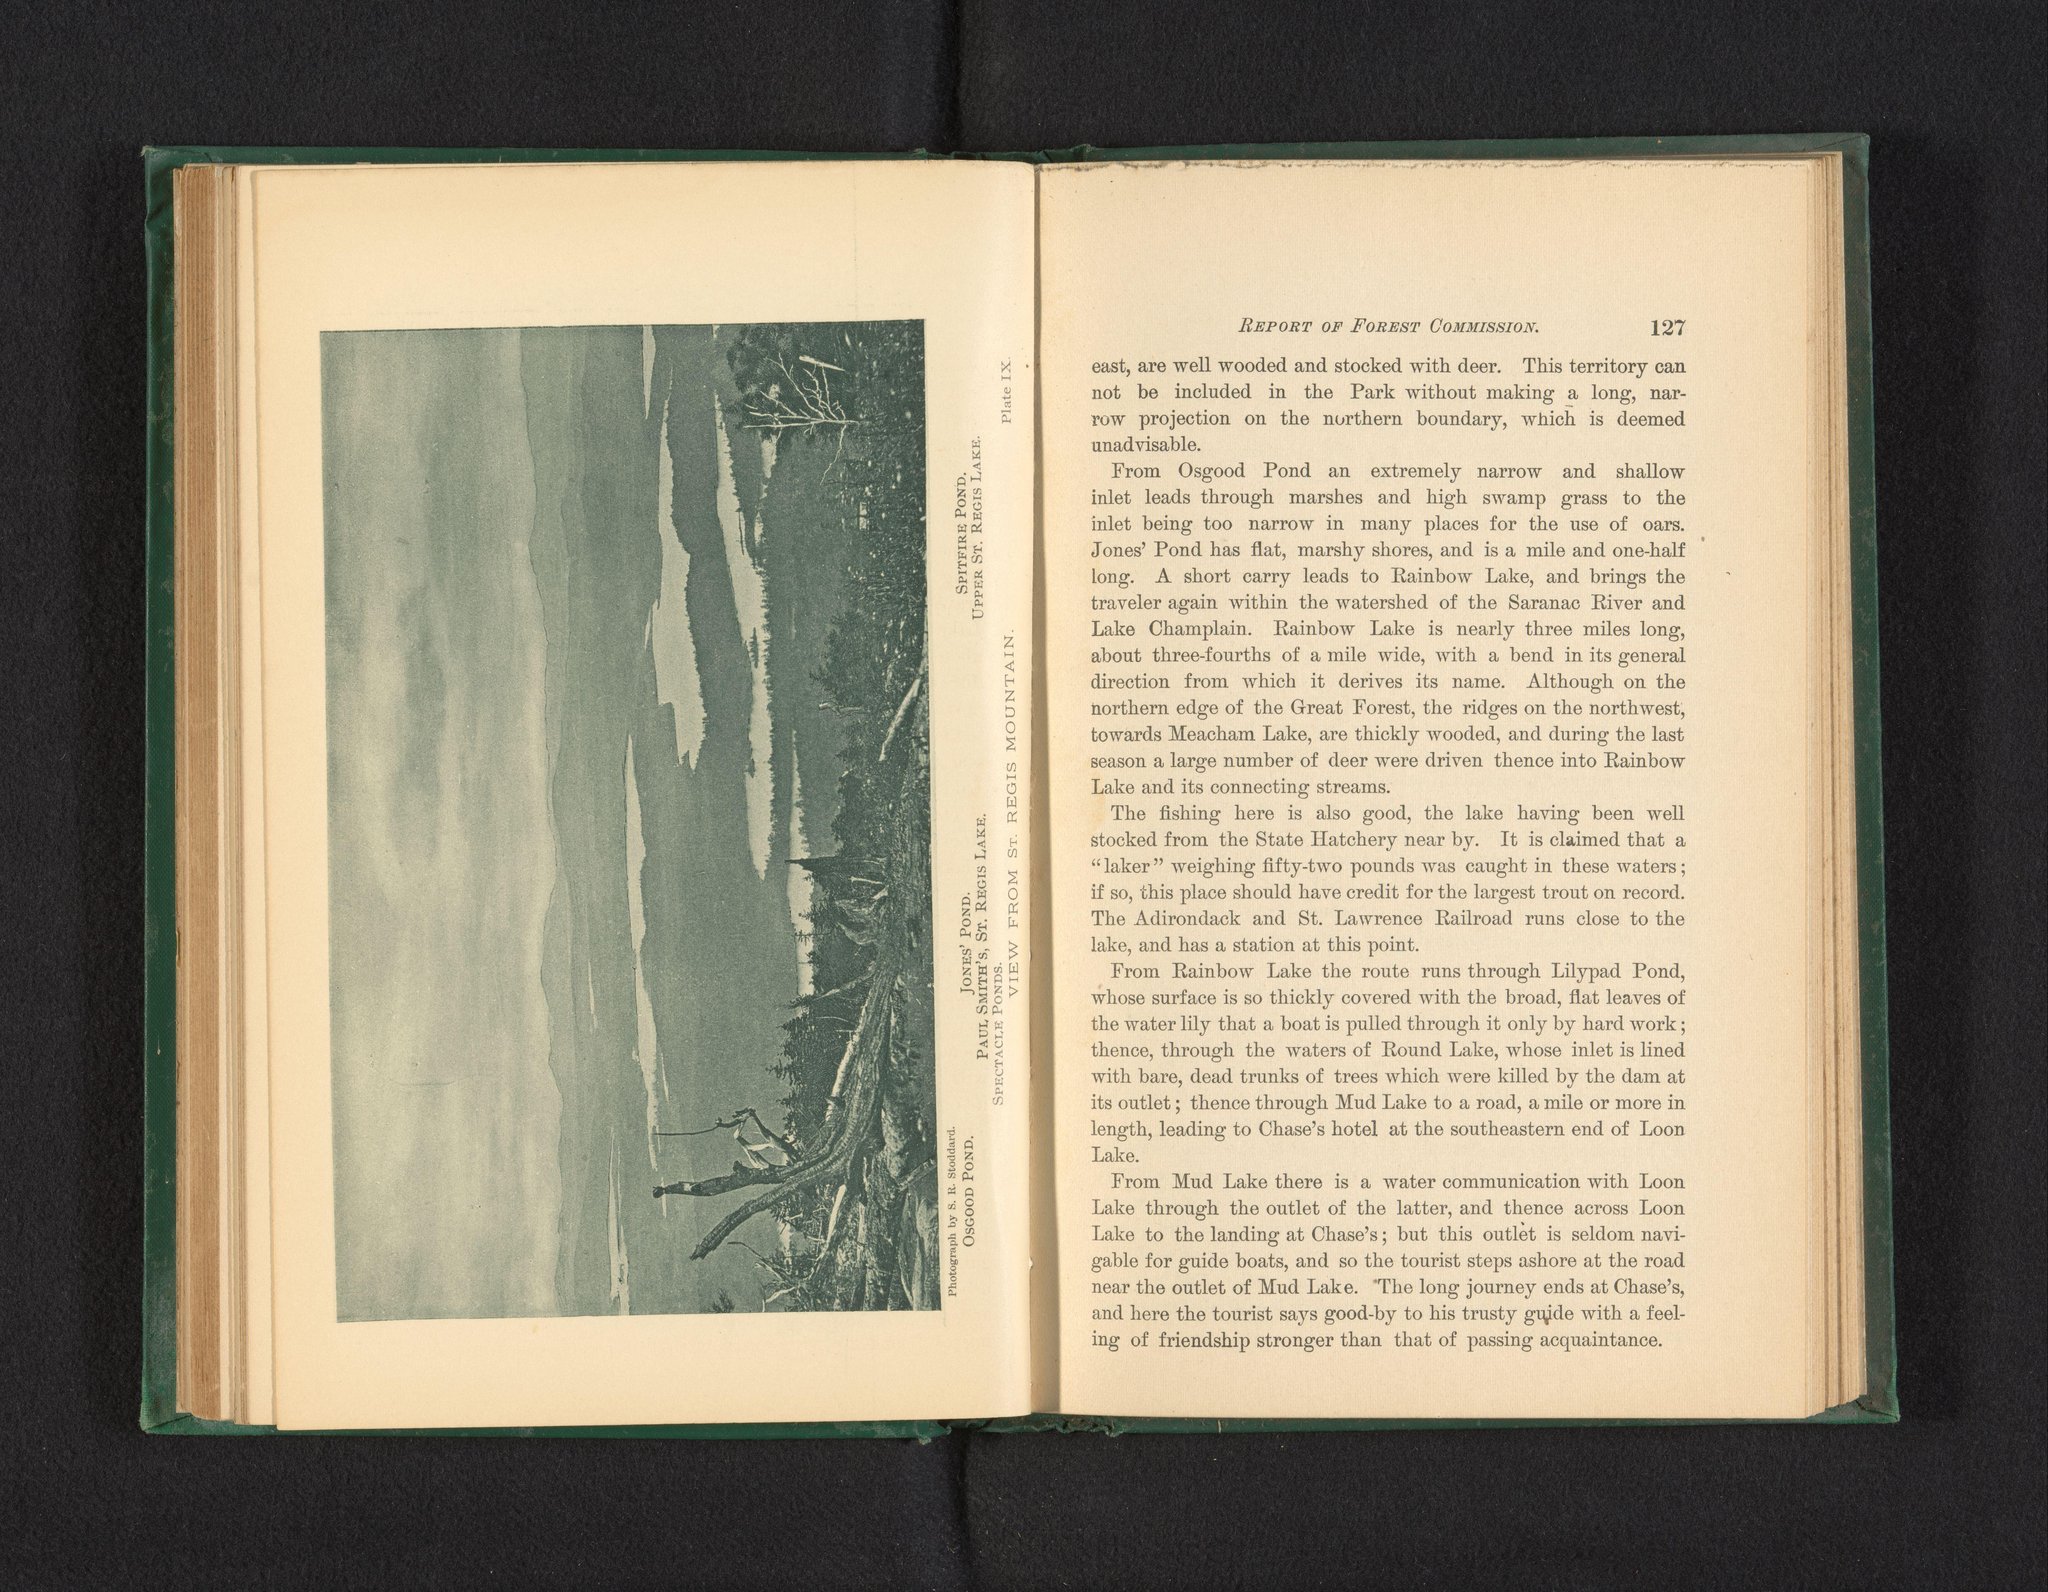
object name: page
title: View from St. Regis Mountain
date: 1891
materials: paper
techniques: photograph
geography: saint regis mountain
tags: landscapes with waters, waterscapes, seascapes (in the temperate zone)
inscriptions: inscription: ‘Osgood Pond (...) Upper St. Regis Lake’, number: ‘Plate IX.’